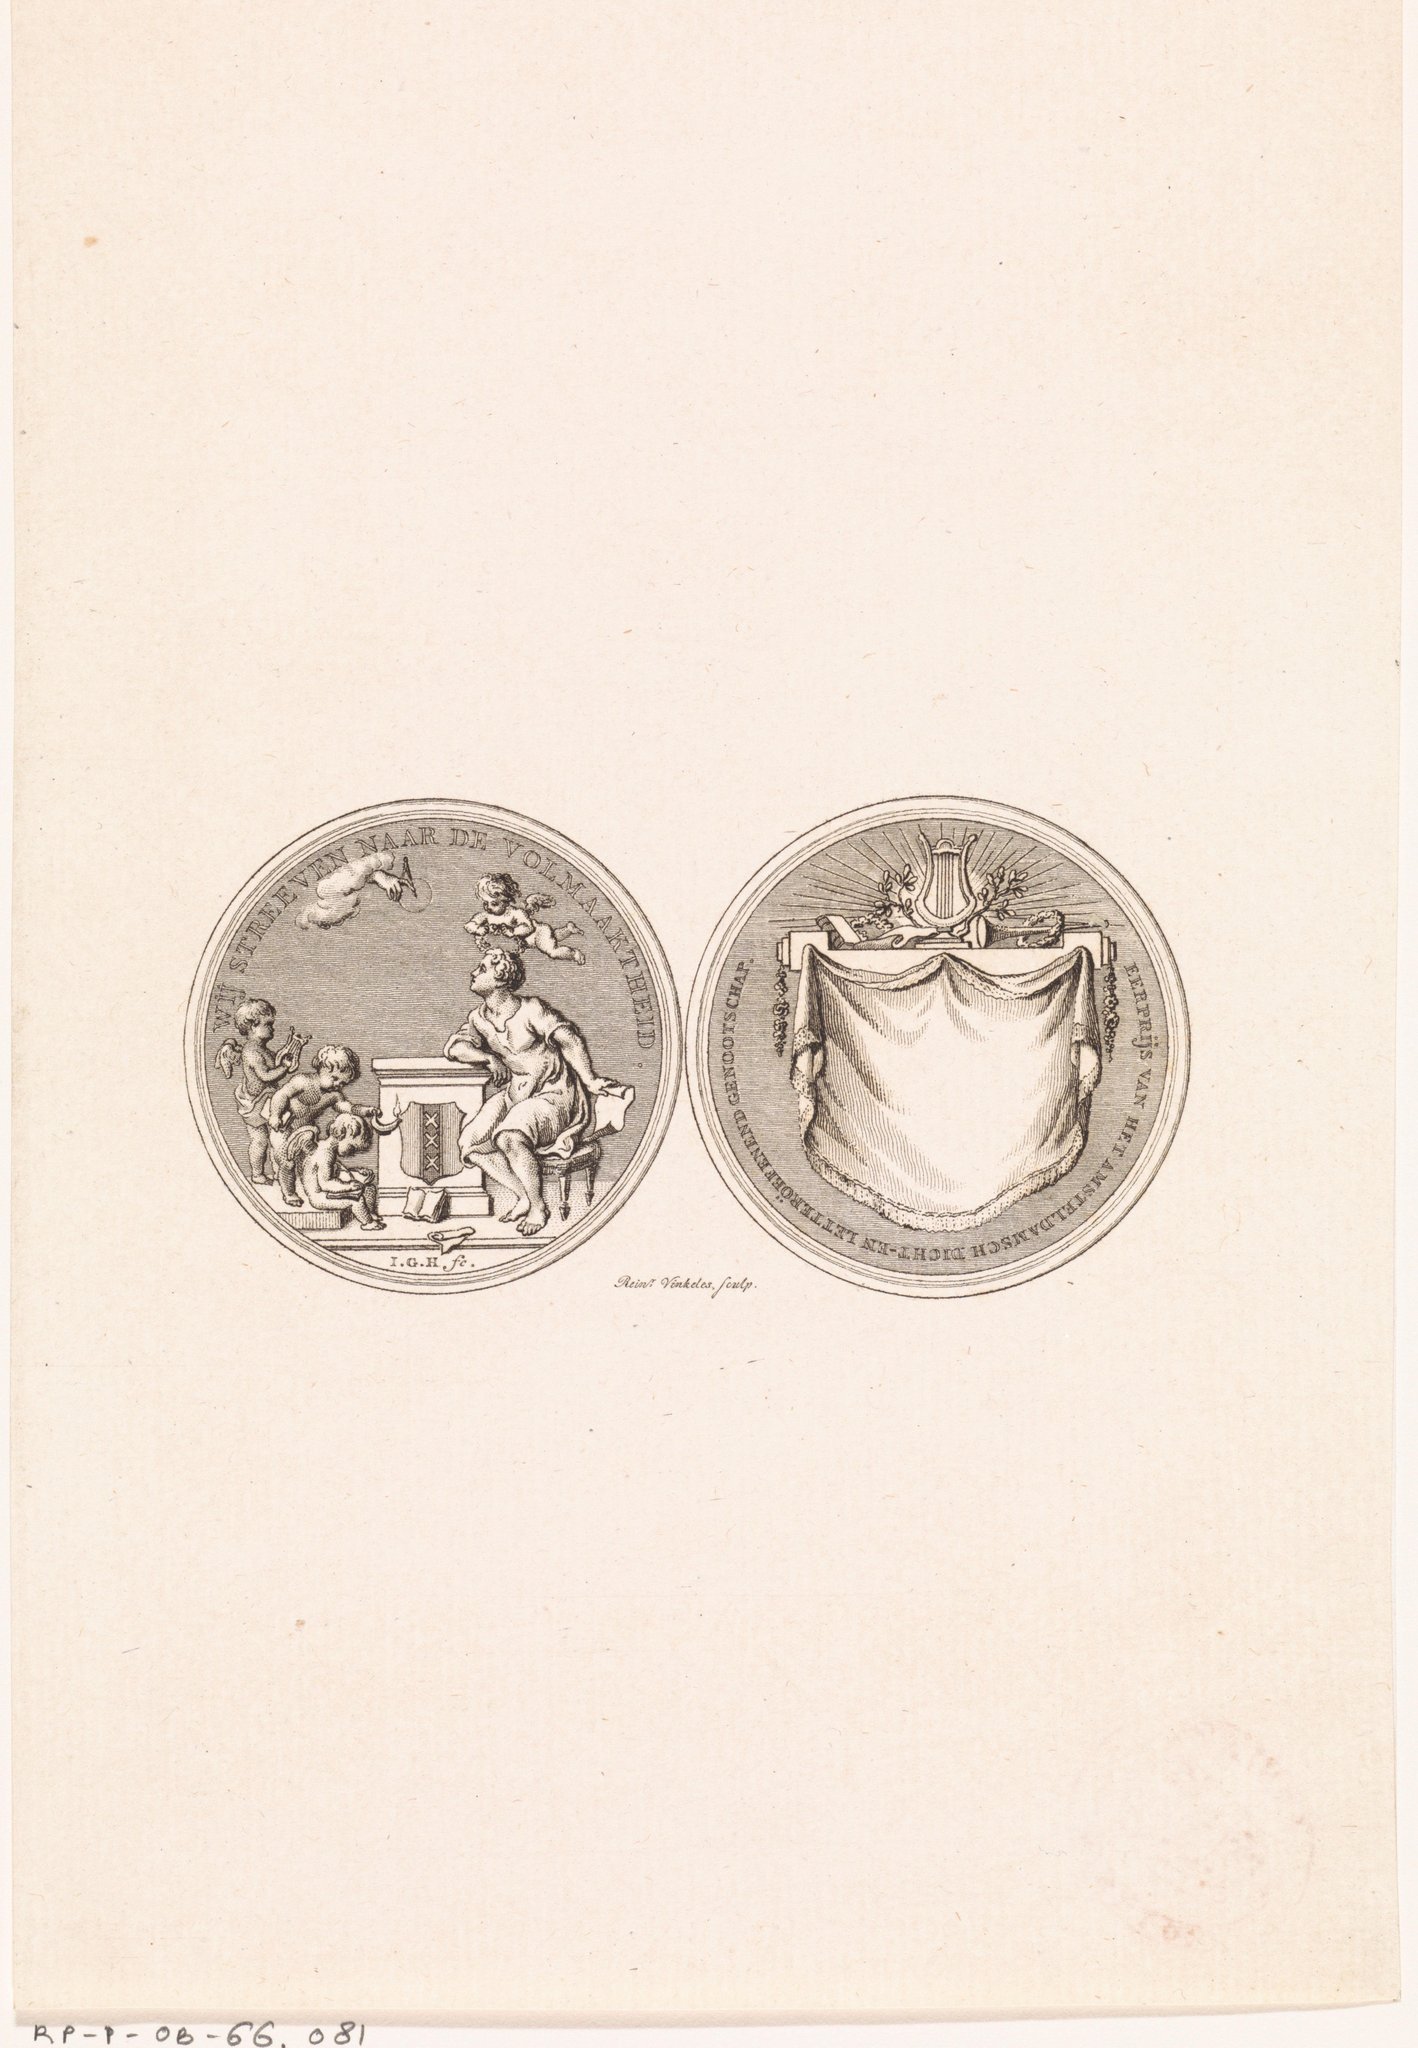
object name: print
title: Medaillon van het Amsteldamsch Dicht- en Letteroefenend Genootschap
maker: reinier vinkeles (i)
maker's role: draughtsman, print maker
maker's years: 1741-1816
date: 1751-1816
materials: paper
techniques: engraving, etching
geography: amsterdam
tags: ornament ~ medallion, writer, poet, author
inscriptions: collector's mark: Lugt 240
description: Twee zijdes van een medaillon van het Amsteldamsch Dicht- en Letteroefenend Genootschap. Links een dichter omringd door putti. In het randschrift: Wij streeven naar de Volmaaktheid. Rechts het randschrift: Eerprijs van het Amsterdamsch Dicht- en Letteröefenend Genootschap.